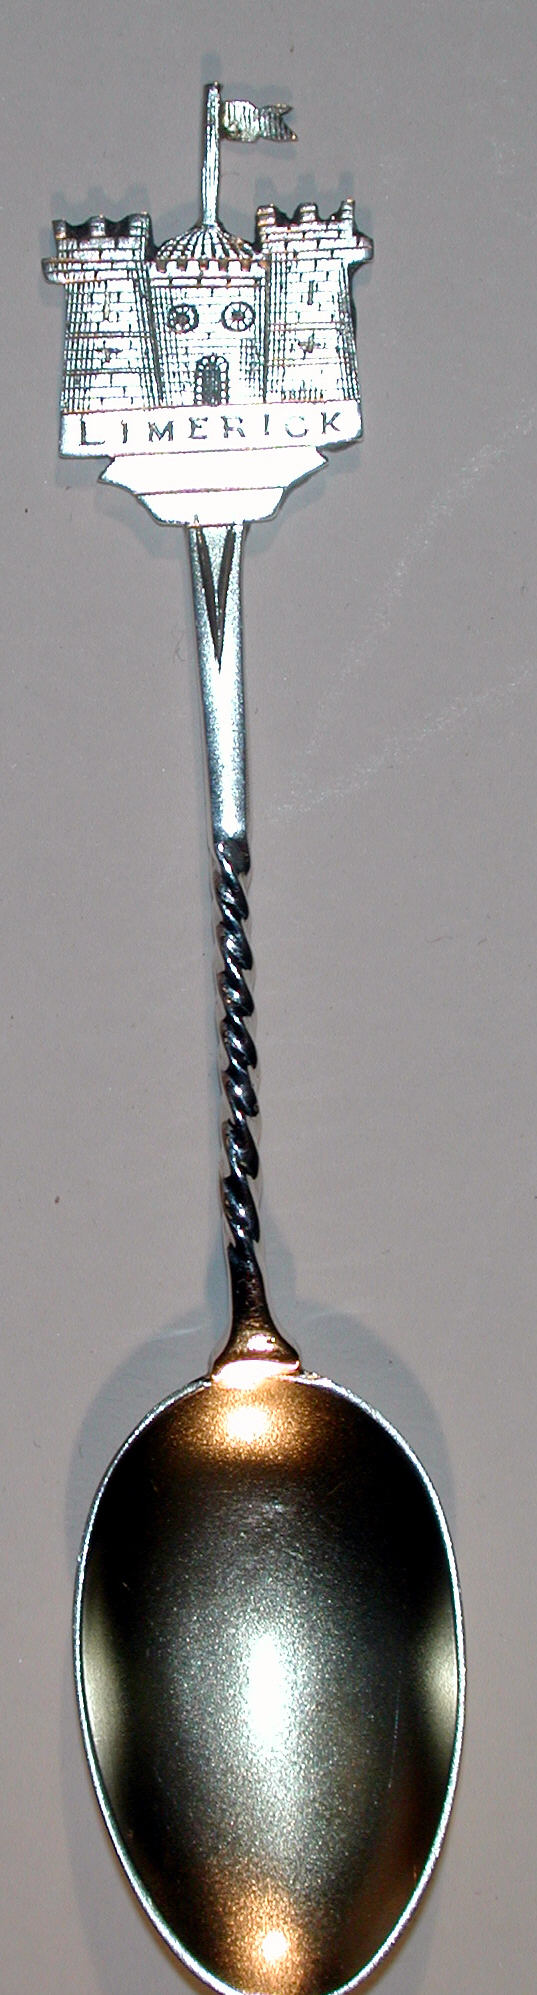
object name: souvenir spoon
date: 1894-1895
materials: silver gilt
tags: buildings,flags